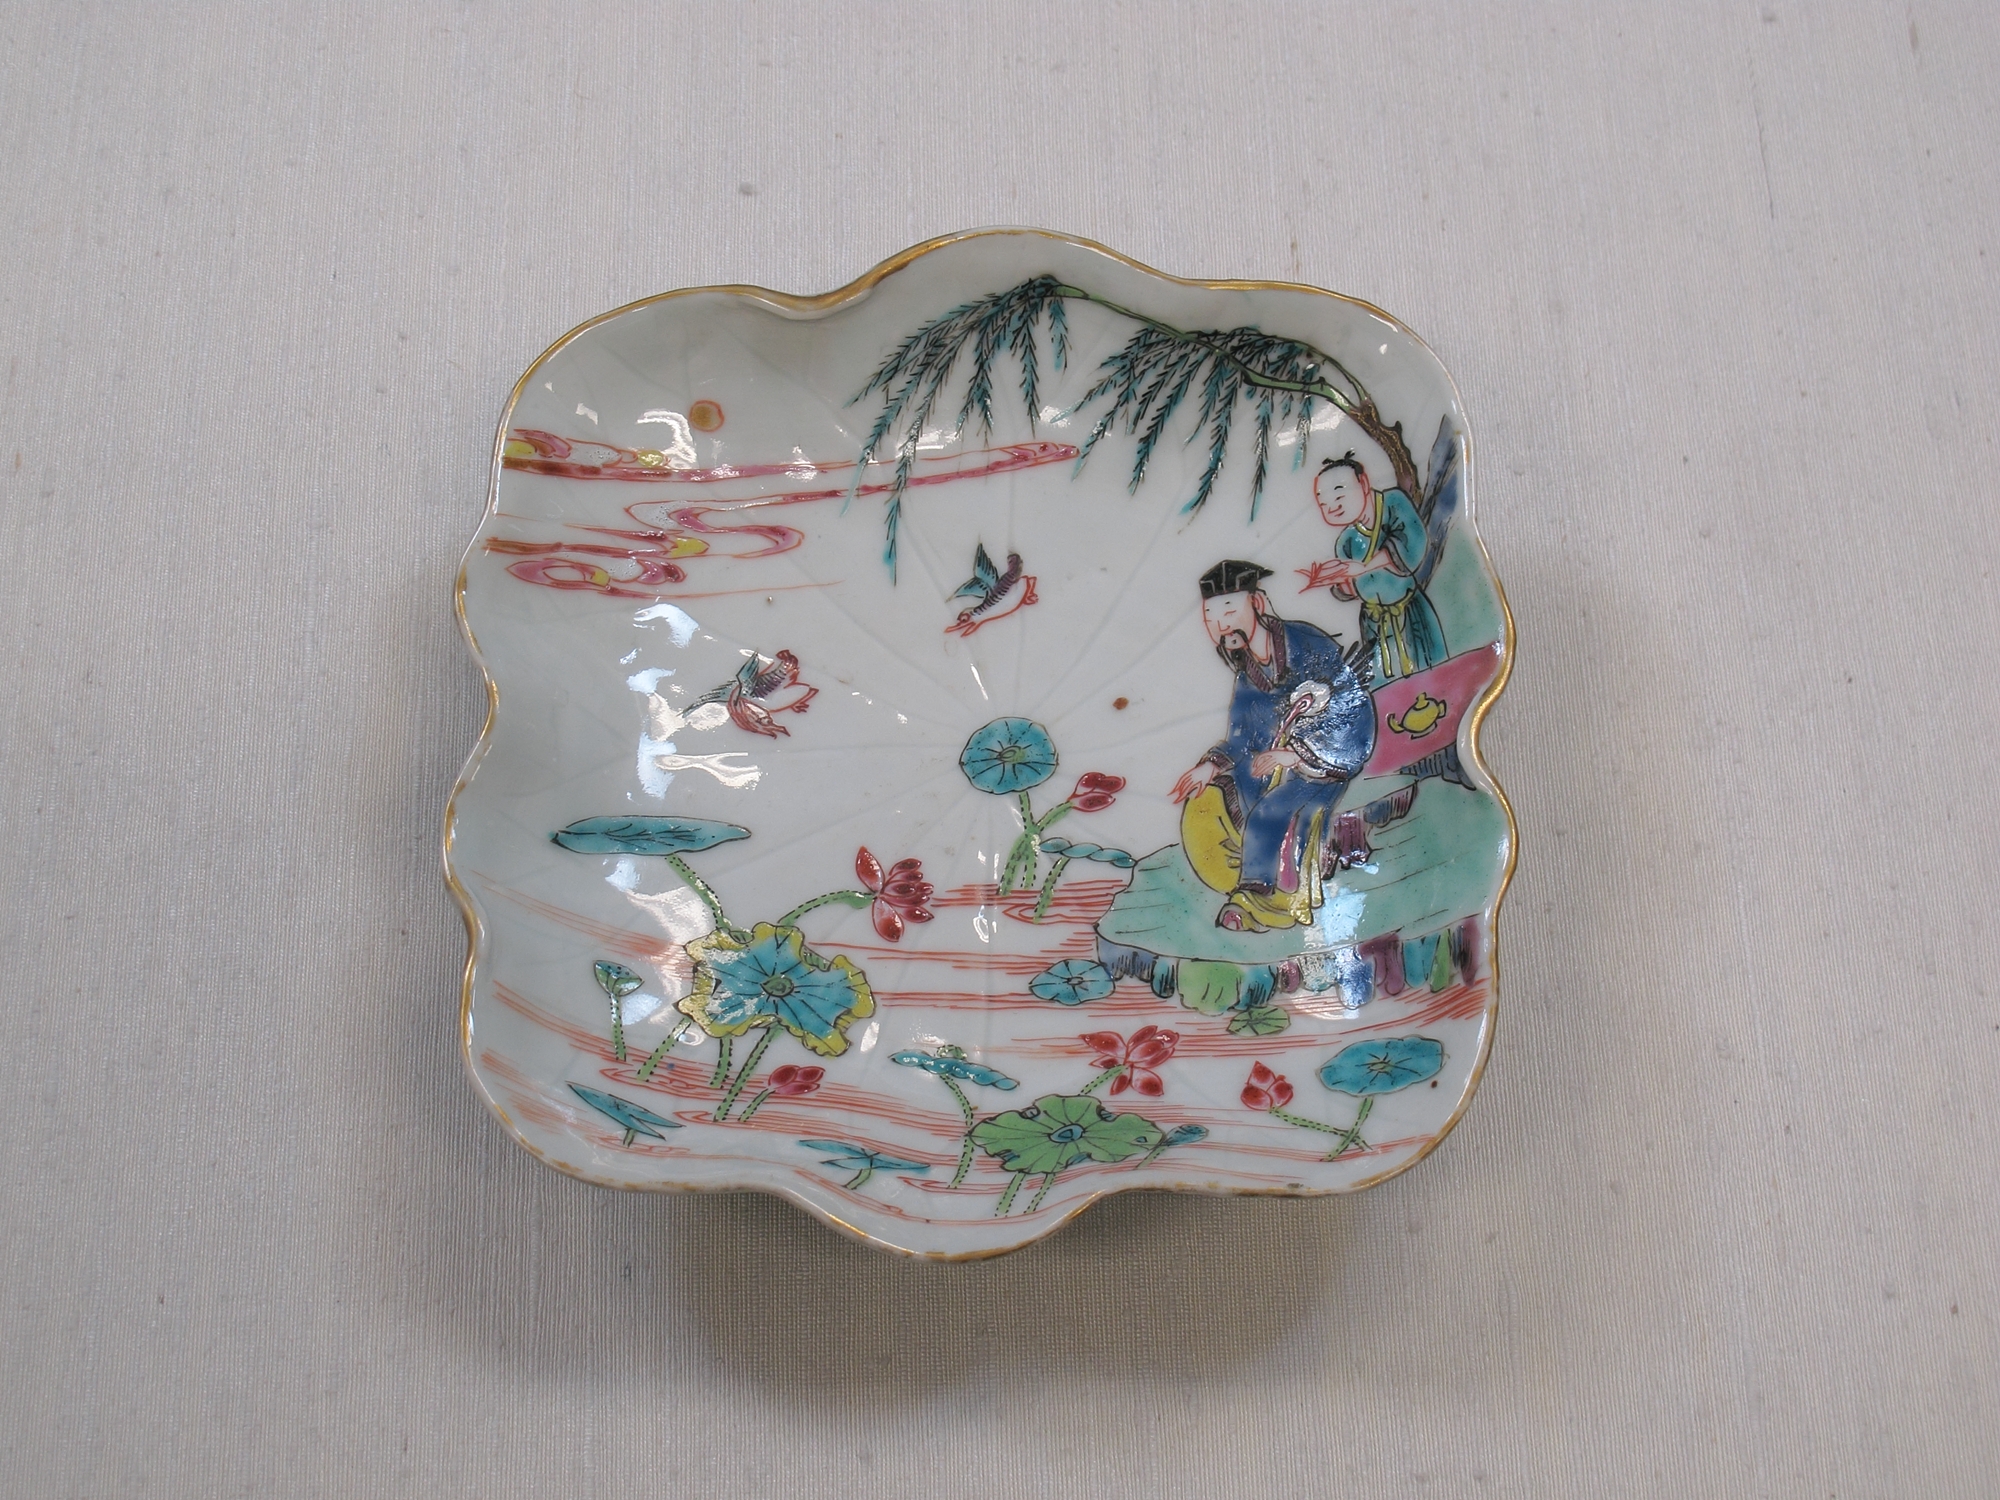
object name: dish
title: Dish with figures by a lotus pond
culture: chinese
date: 1767-1800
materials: enamel, porcelain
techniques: overglaze, painting, polychrome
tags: men,lotuses,trees